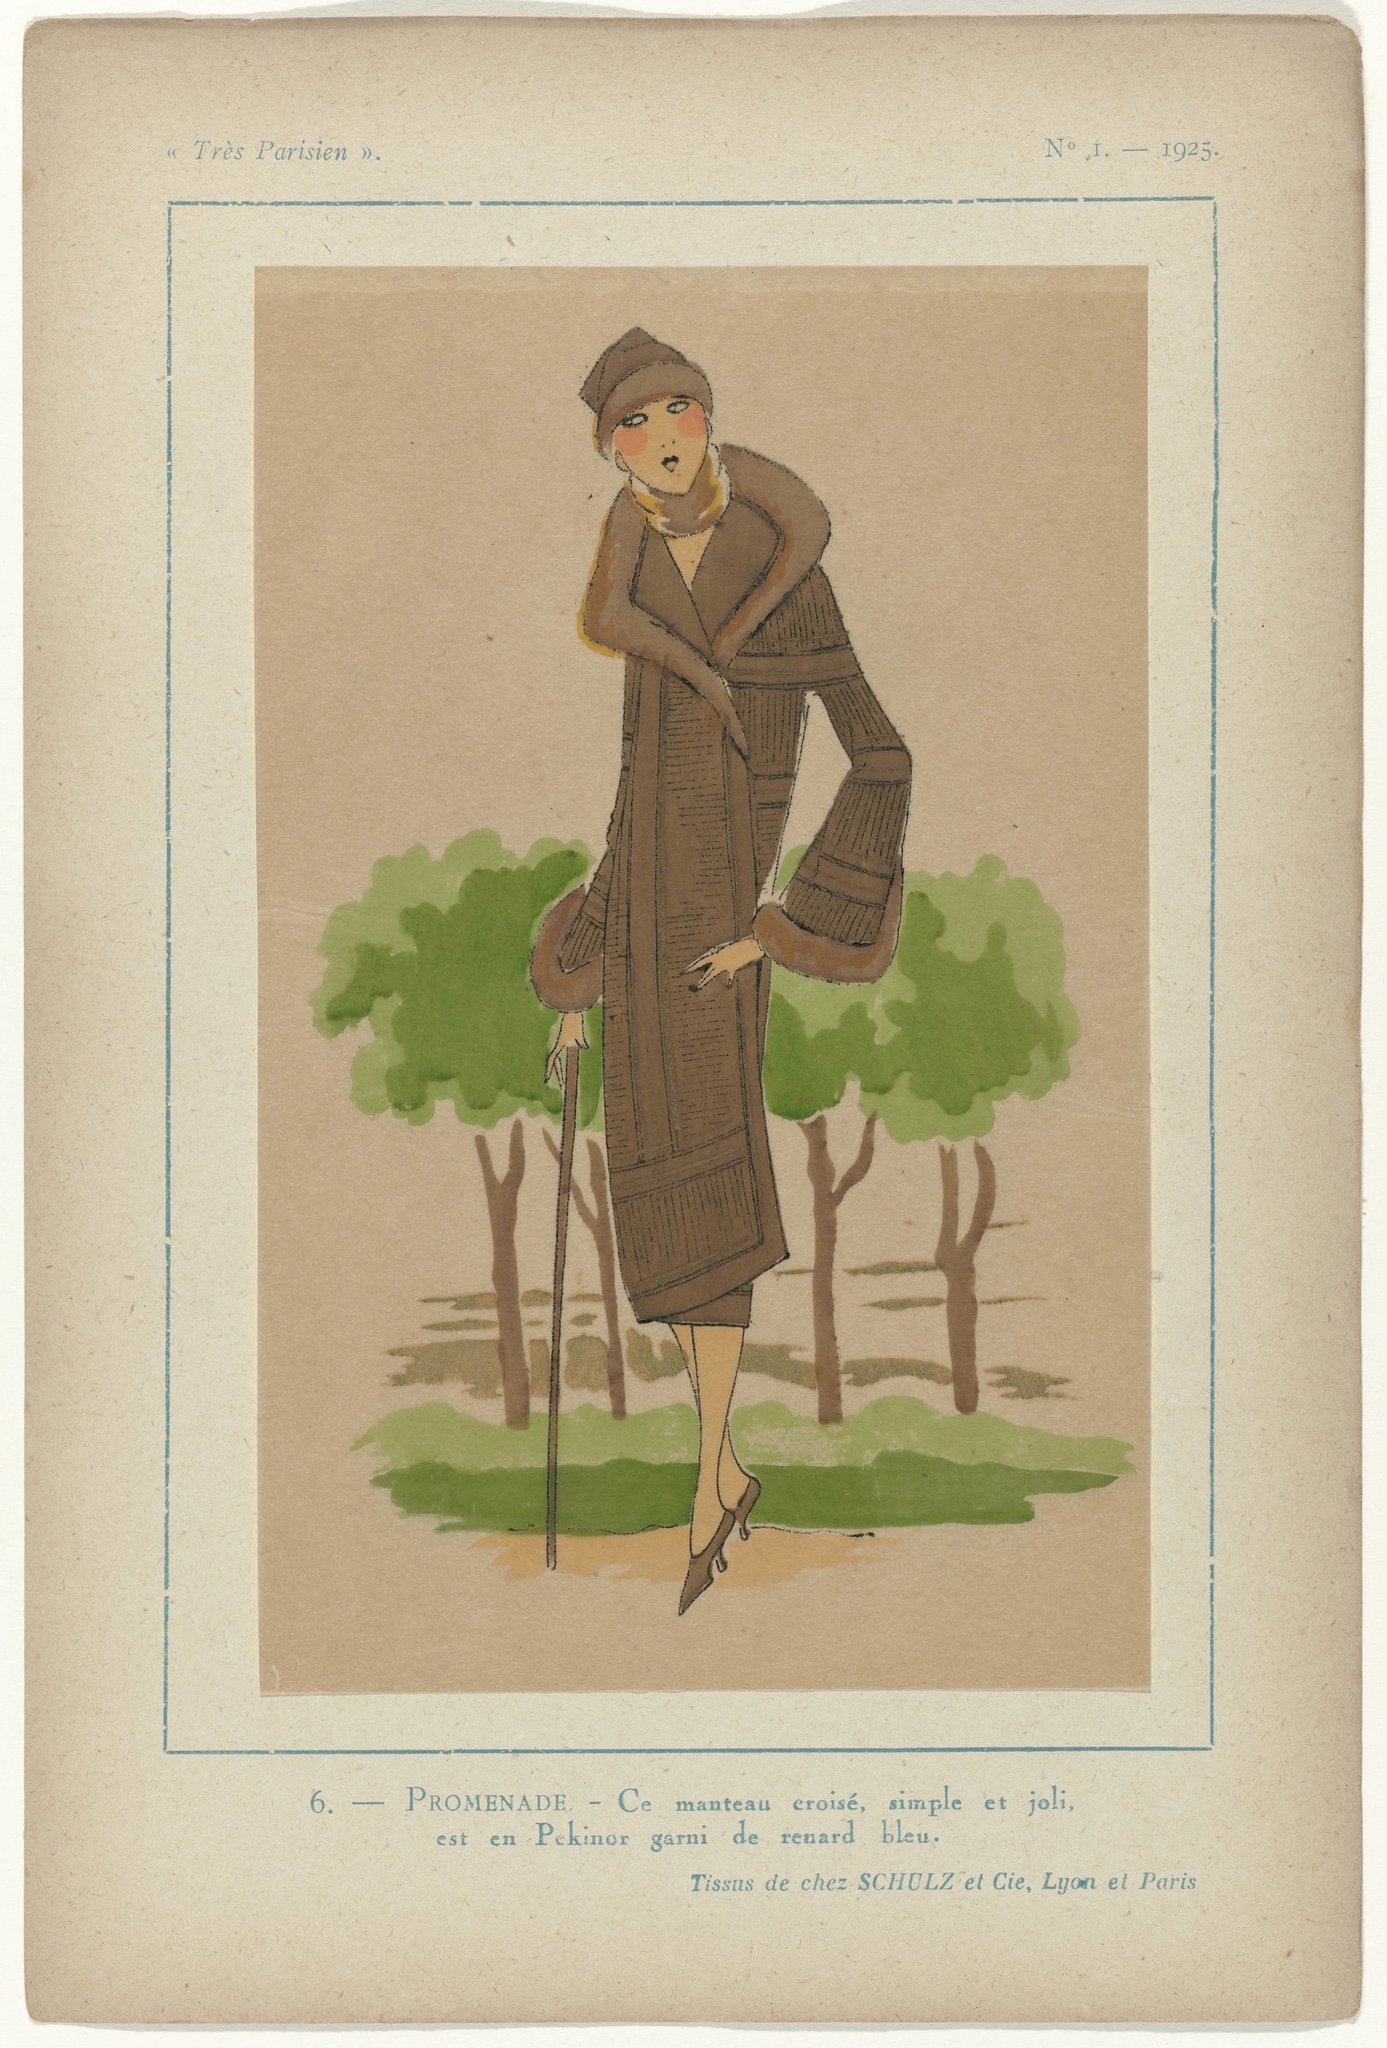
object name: fashion print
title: Très Parisien, 1925, No. 1, Pl. 6: - PROMENADE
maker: g-p. joumard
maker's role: publisher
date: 1925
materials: paper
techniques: hand coloring, letterpress printing, lithography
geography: paris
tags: walking-stick, staff, cane (+ women's clothes), coat (+ women's clothes), fashion plates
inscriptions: caption: ‘PROMENADE. - Ce manteau croisé, simple et joli, est en Pekinor garni de renard bleu.’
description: Promenade: Eenvoudige bruine mantel, afgezet met vossenbont. Stoffen van Schultz & Co uit Lyon en Parijs. Bijpassend hoedje met bontrand. Prent uit het modetijdschrift Très Parisien...La Mode, Le Chic, L'Élégance (1920-1936)